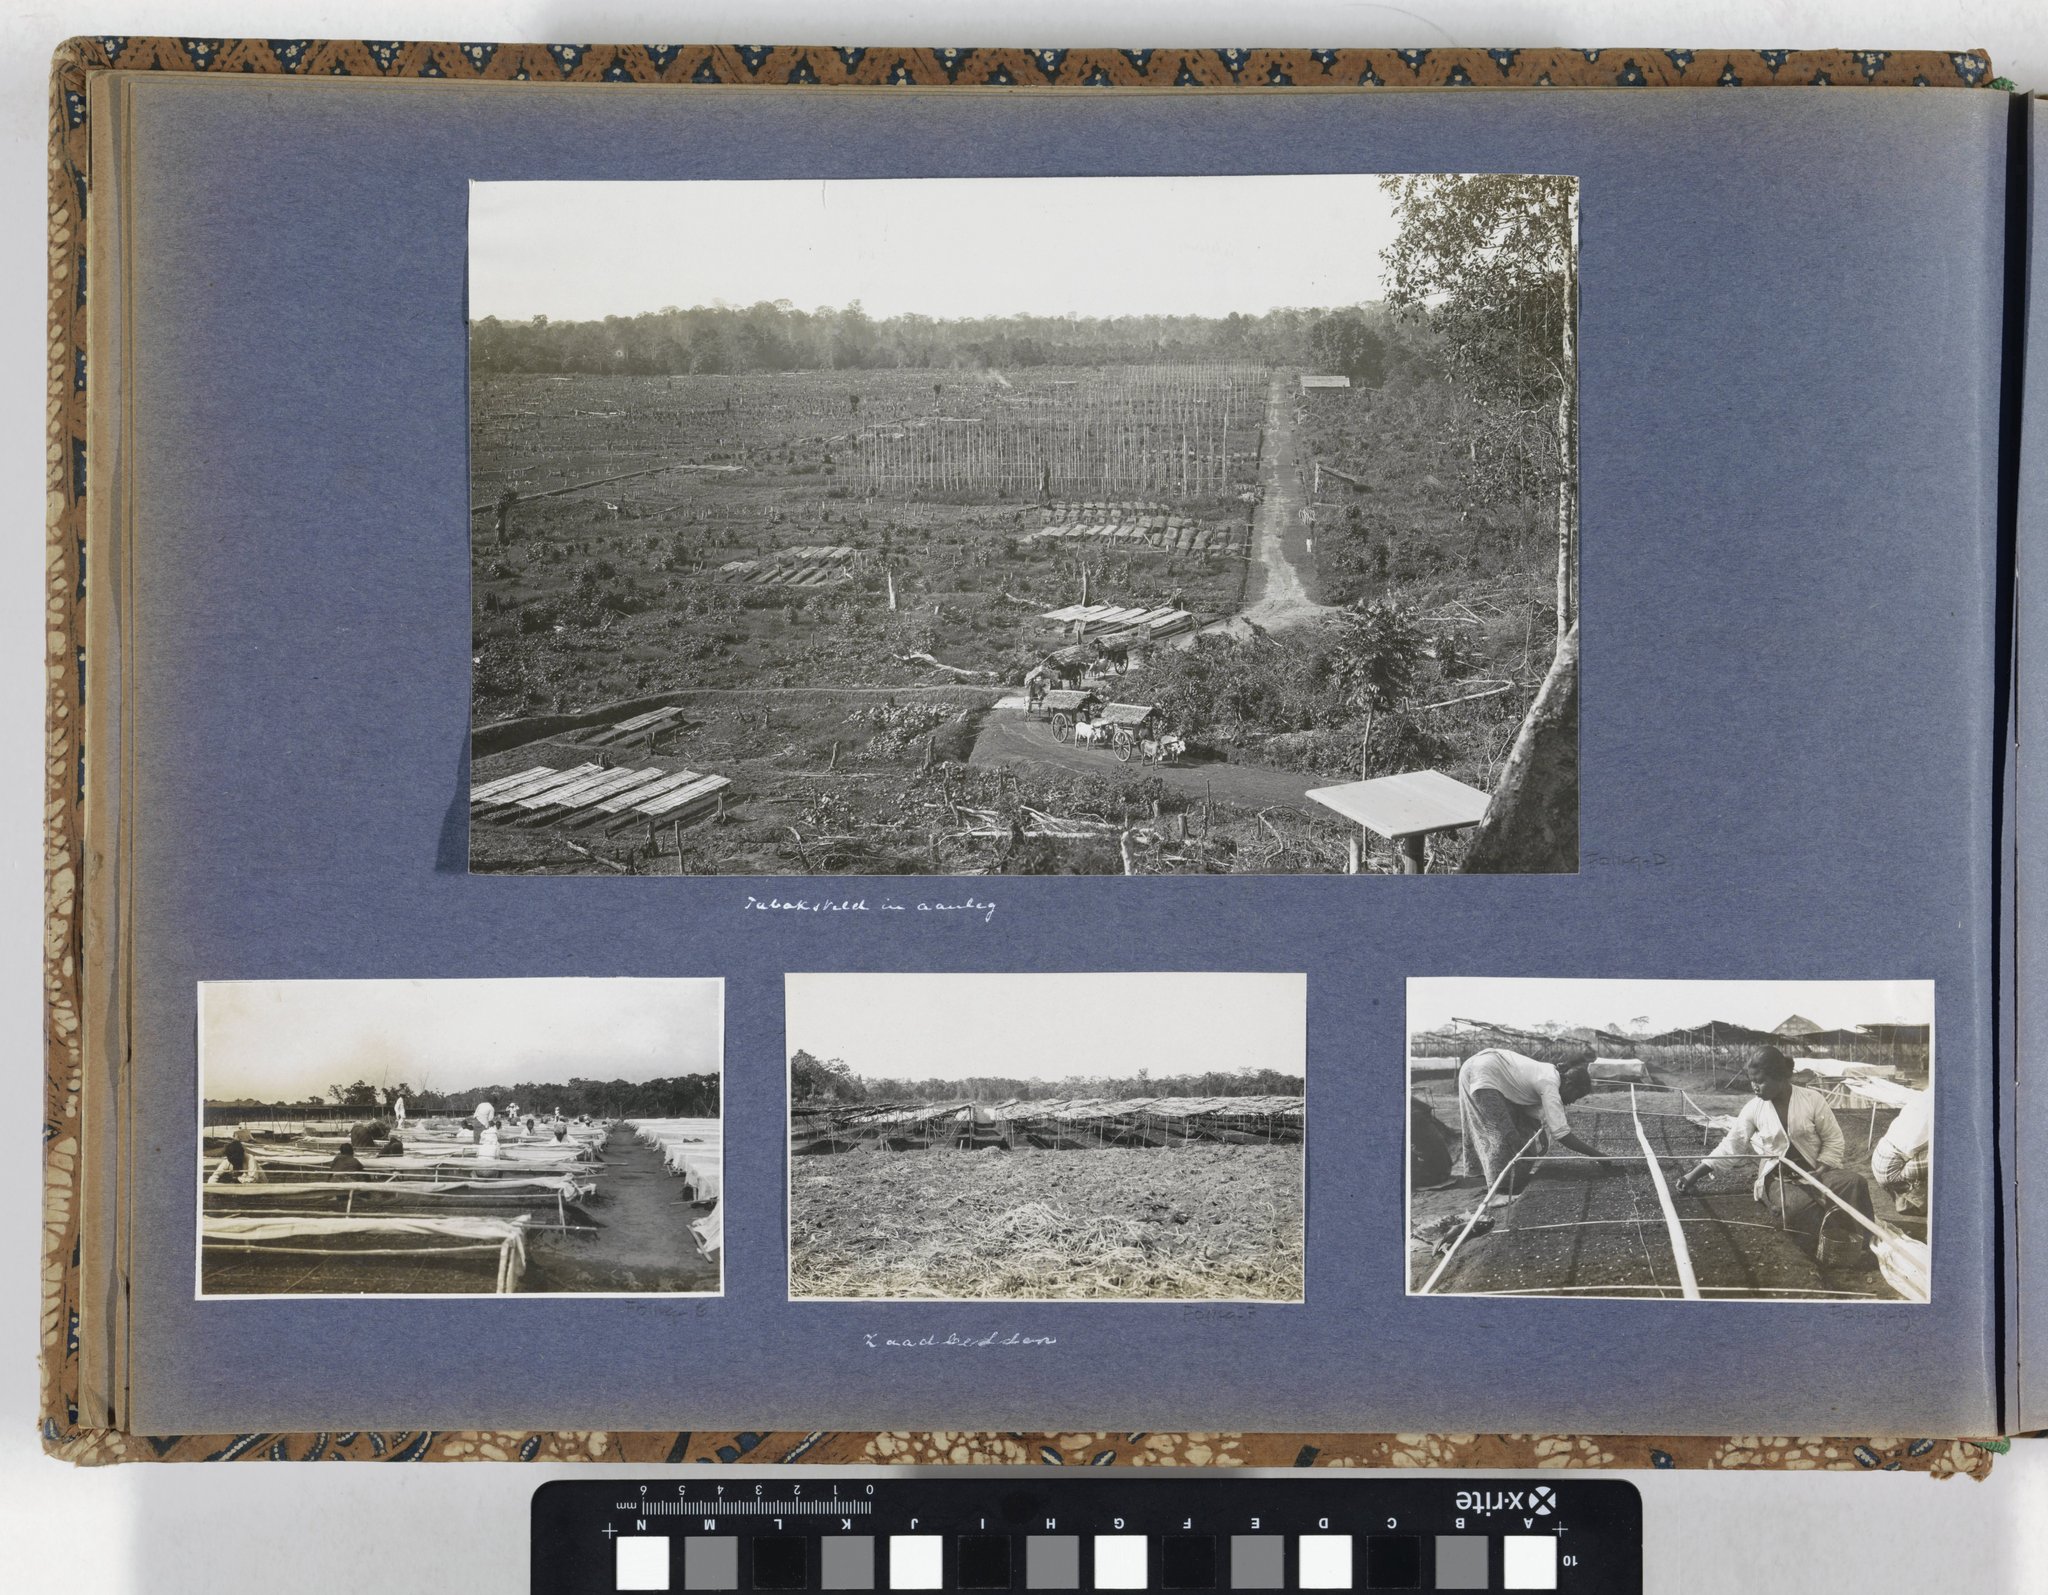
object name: photograph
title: Zaadbedden op Sumatra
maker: Anonymous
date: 1900-1920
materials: paper, photographic support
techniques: gelatin silver print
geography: sumatra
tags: plantation, tobacco, sumatra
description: Onderdeel van reisalbum met foto's van bedrijvigheid en bezienswaardigheden op Sumatra en Java en van de reis naar en van Nederlands-Indië.